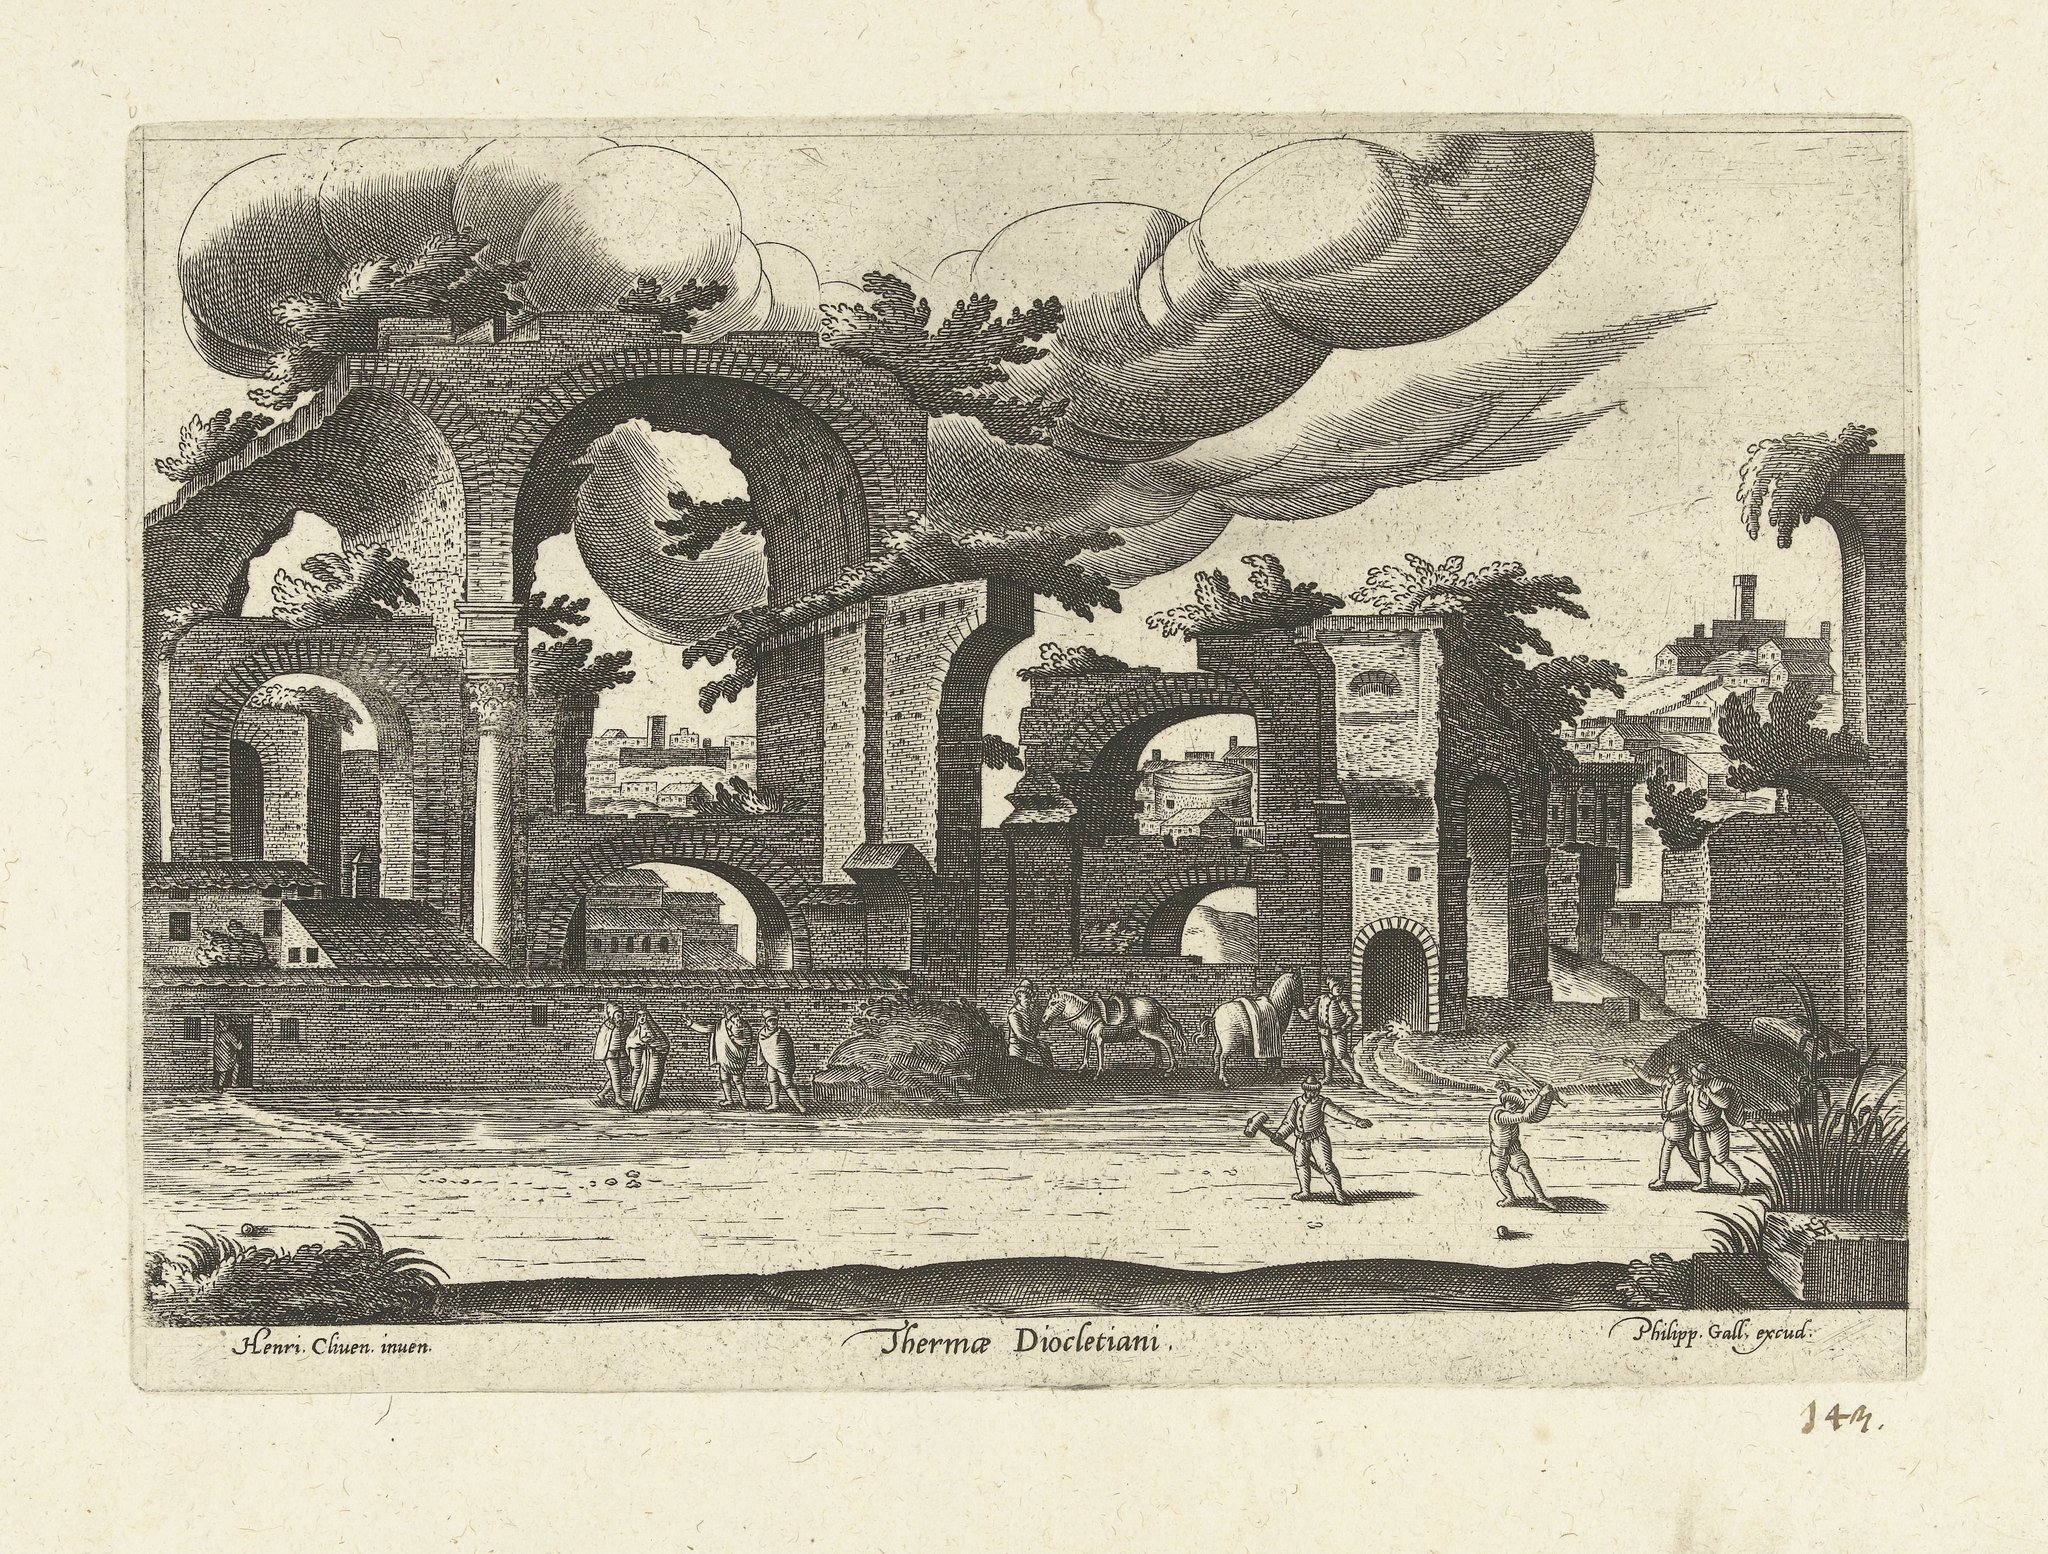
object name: print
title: Ruinarum varii prospectus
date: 1585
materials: paper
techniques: engraving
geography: antwerp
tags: ruin of a building ~ architecture, croquet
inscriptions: number: ‘143’, collector's mark: Lugt 2228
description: Gezicht op de ruïne van de thermen van Diocletianus van langszij. Op de voorgrond enkele wandelaars en twee mannen die croquet spelen. De prent is deel van een serie die verschillende plaatsen in het Middellandse Zeegebied afbeeldt.